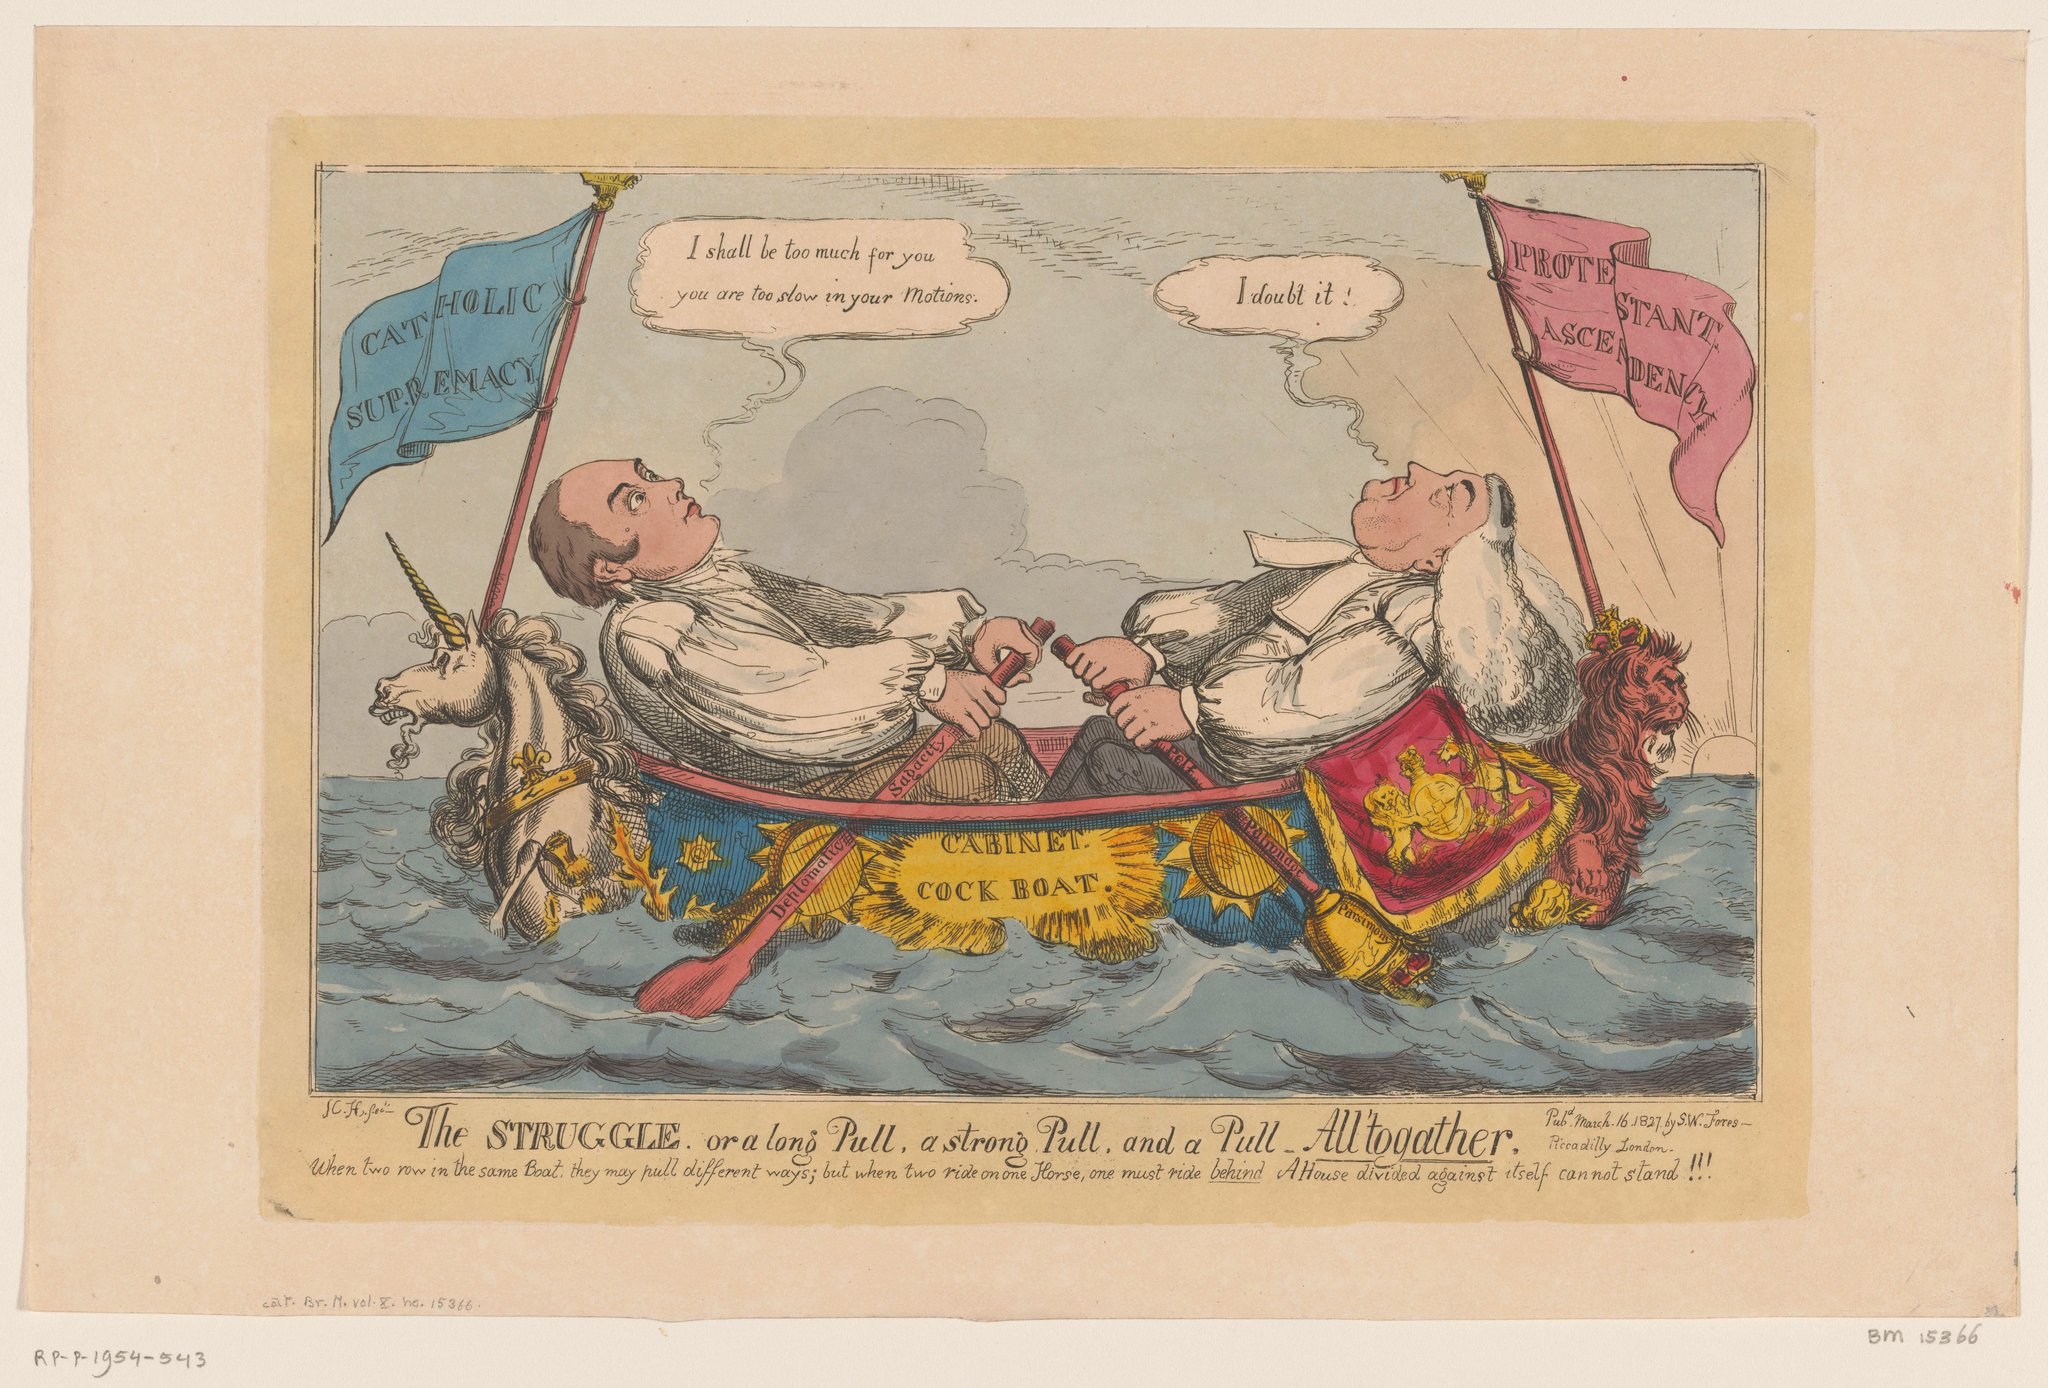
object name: cartoon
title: Spotprent op de spanningen in het Britse kabinet tussen de Katholieken en de Protestanten, 1827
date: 1827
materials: paper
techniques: etching, hand coloring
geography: london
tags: politician, london, protestant churches and denominations, roman catholic church, rowing facing backward, pulling, political caricatures and satires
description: Spotprent op de spanningen in het Britse kabinet tussen de Katholieken en de Protestanten in maart 1827. De vertegenwoordigers van beide partijen, respectievelijk, Canning en Eldon, zitten samen een roeibootje dat het koninkrijk symboliseert (Cabinet cock boat), en proberen in tegenovergestelde richtingen te roeien.